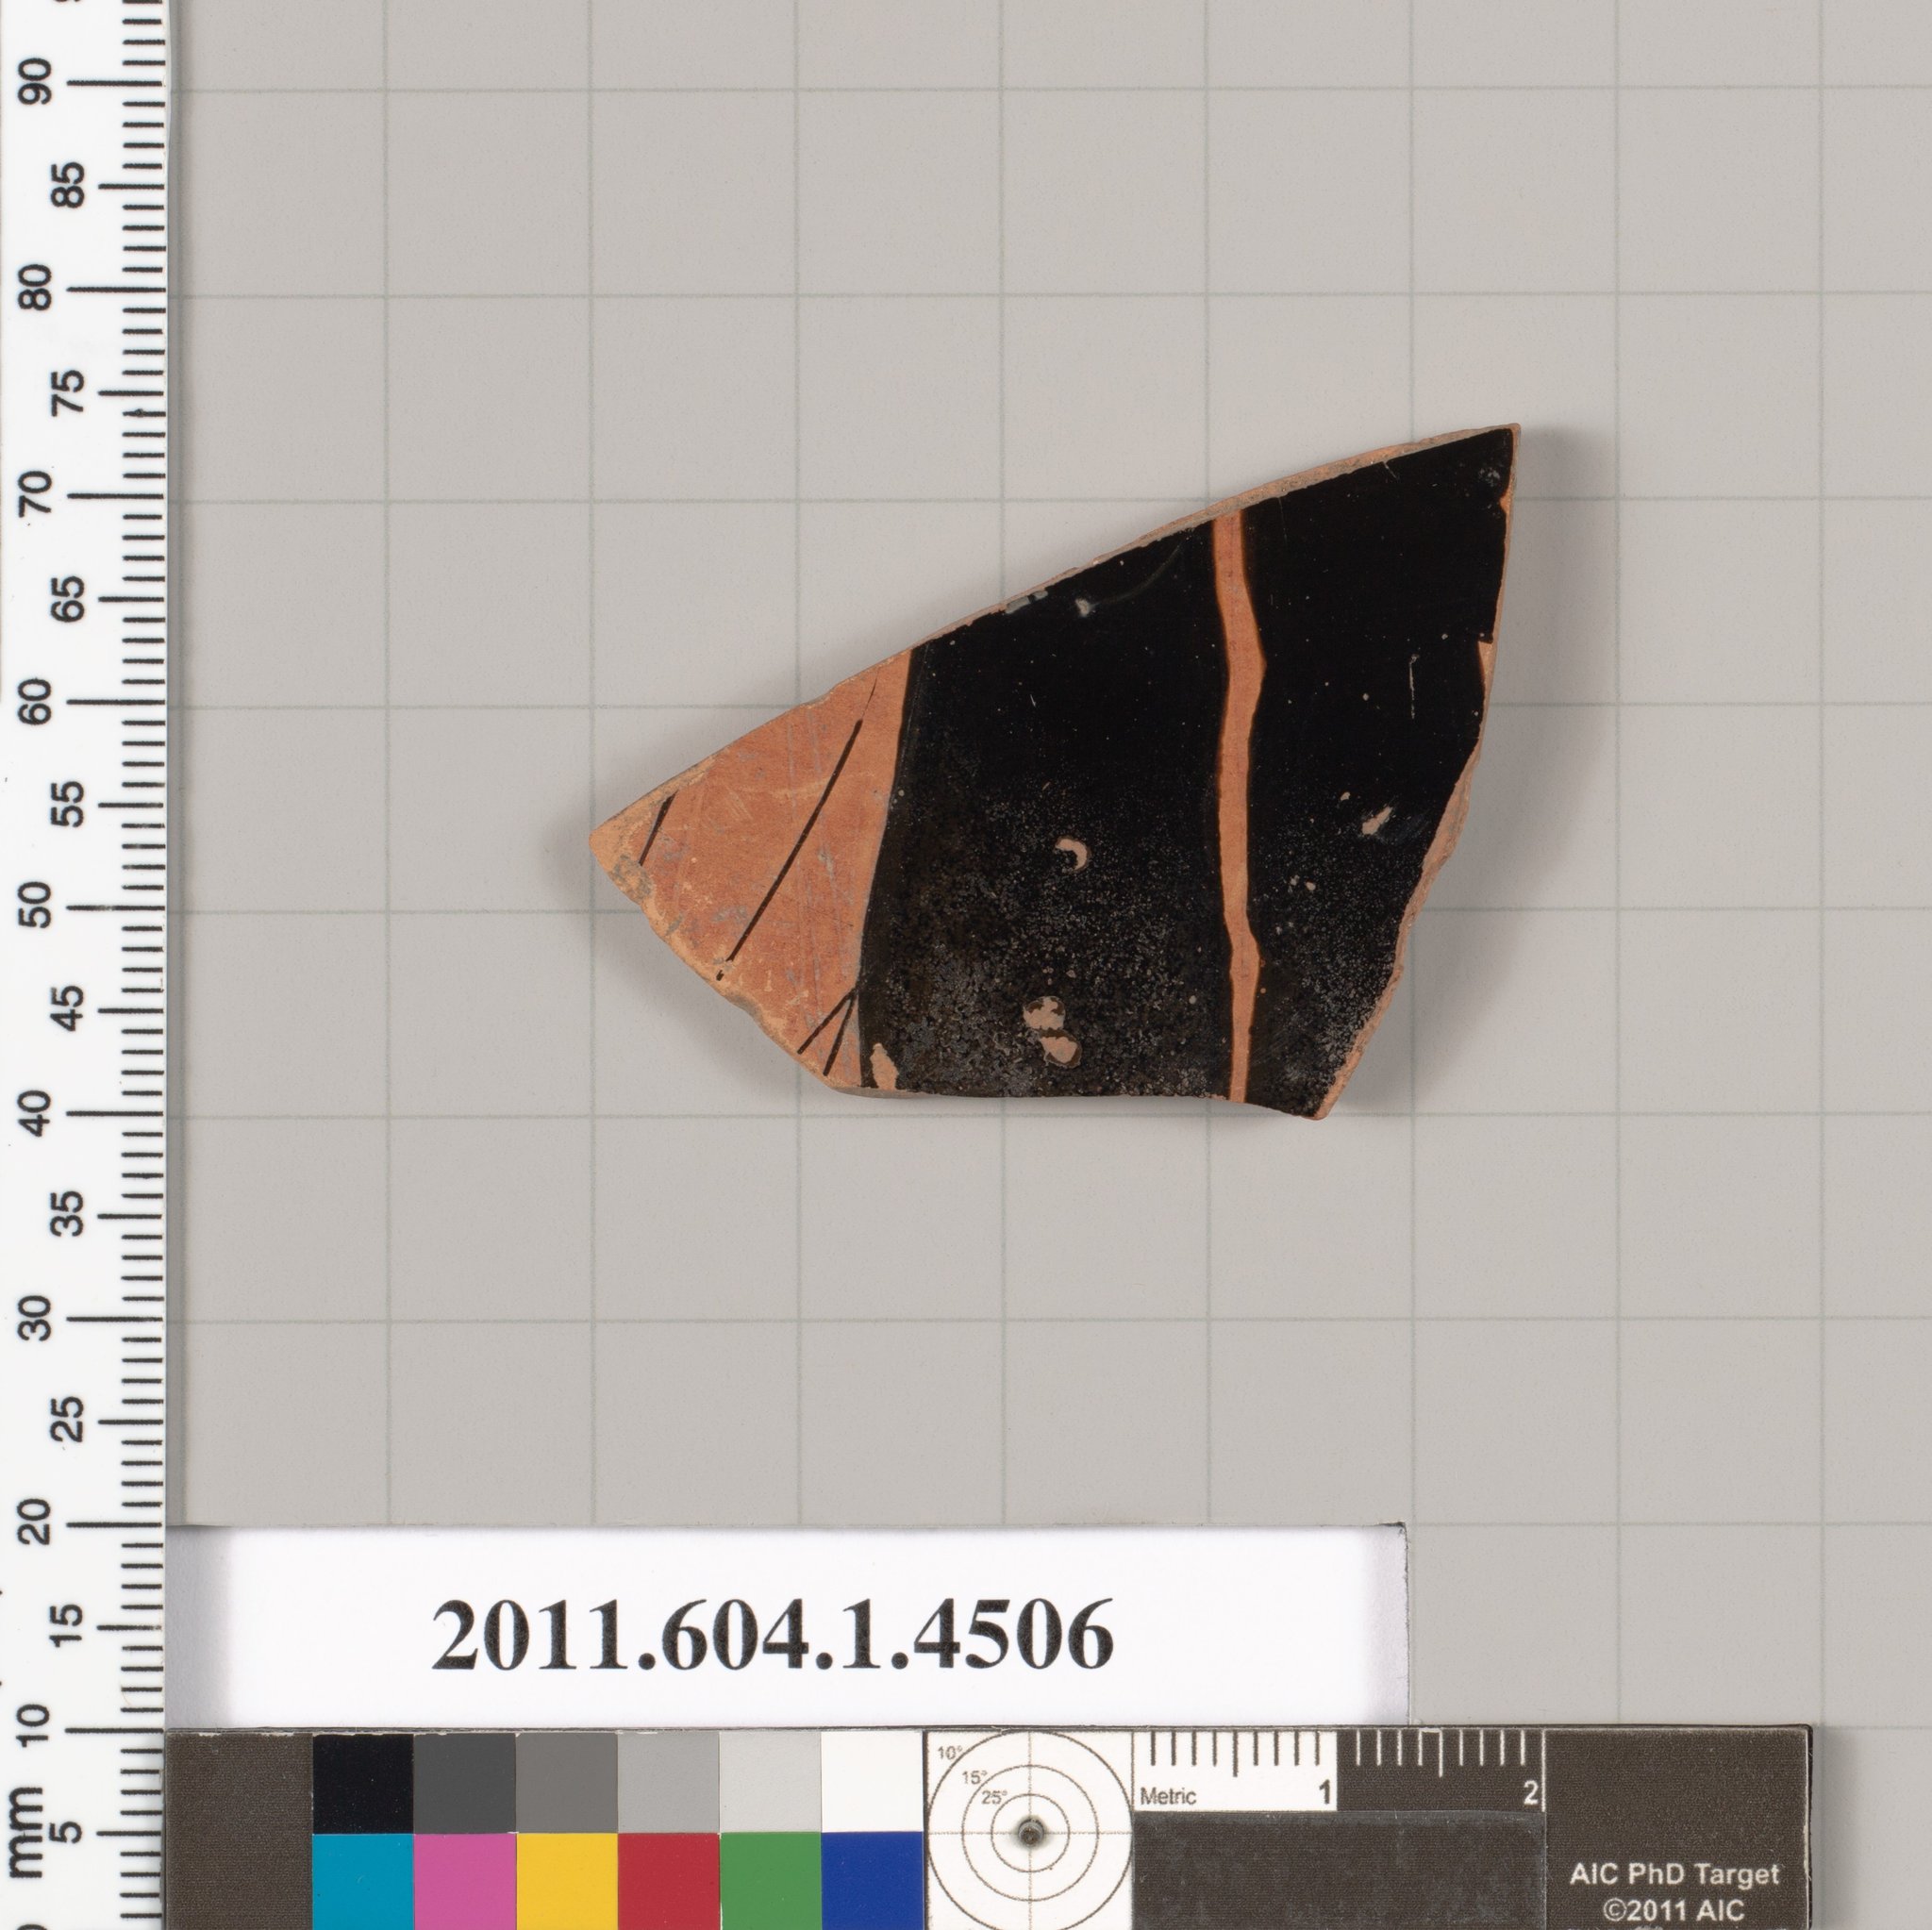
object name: kylix fragment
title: Terracotta fragment of a kylix (drinking cup)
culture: greek, attic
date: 475-451 BCE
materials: terracotta